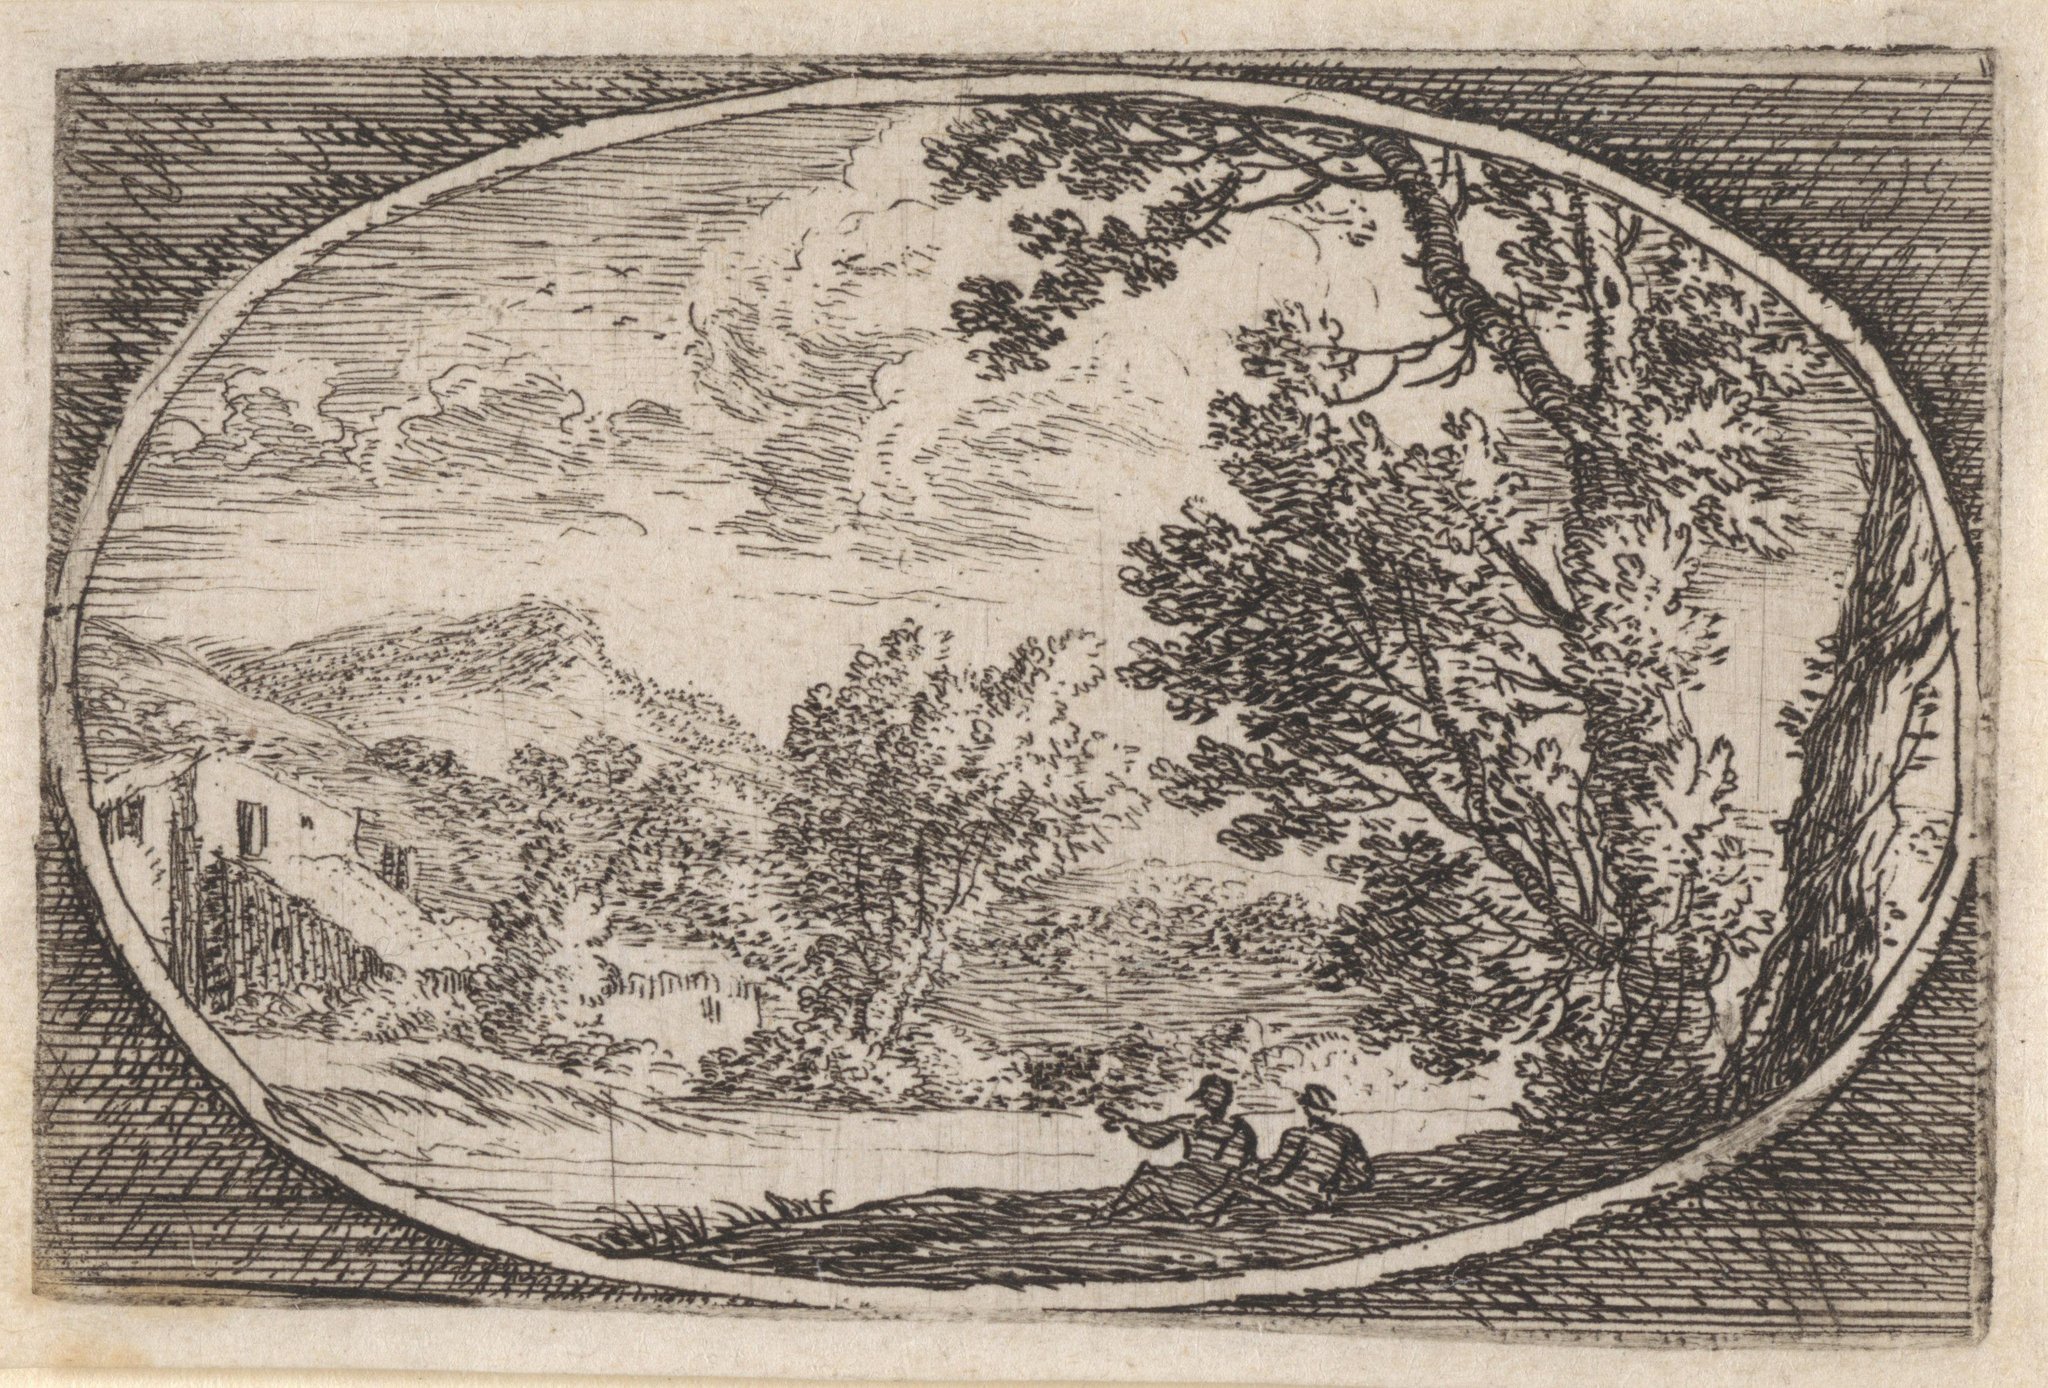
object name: print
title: Ovale fantasielandschappen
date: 1650-1655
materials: paper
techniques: etching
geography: paris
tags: landscapes, river, river bank, rural housing, e.g. country-house, villa, cottage, (high) hill, sitting on the ground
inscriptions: collector's mark: Lugt 240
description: In een ovale omlijsting zitten twee figuren onder een boom aan de waterkant. Aan de overkant van de rivier staat een gebouw aan de voet van een heuvel.